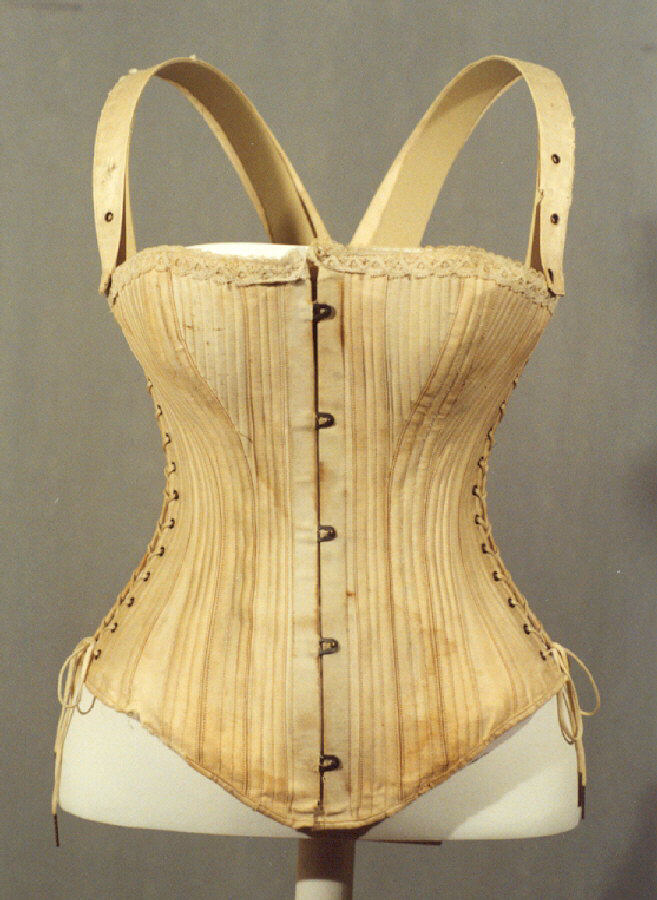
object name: corset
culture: american or european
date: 1880-1889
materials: cotton, metal